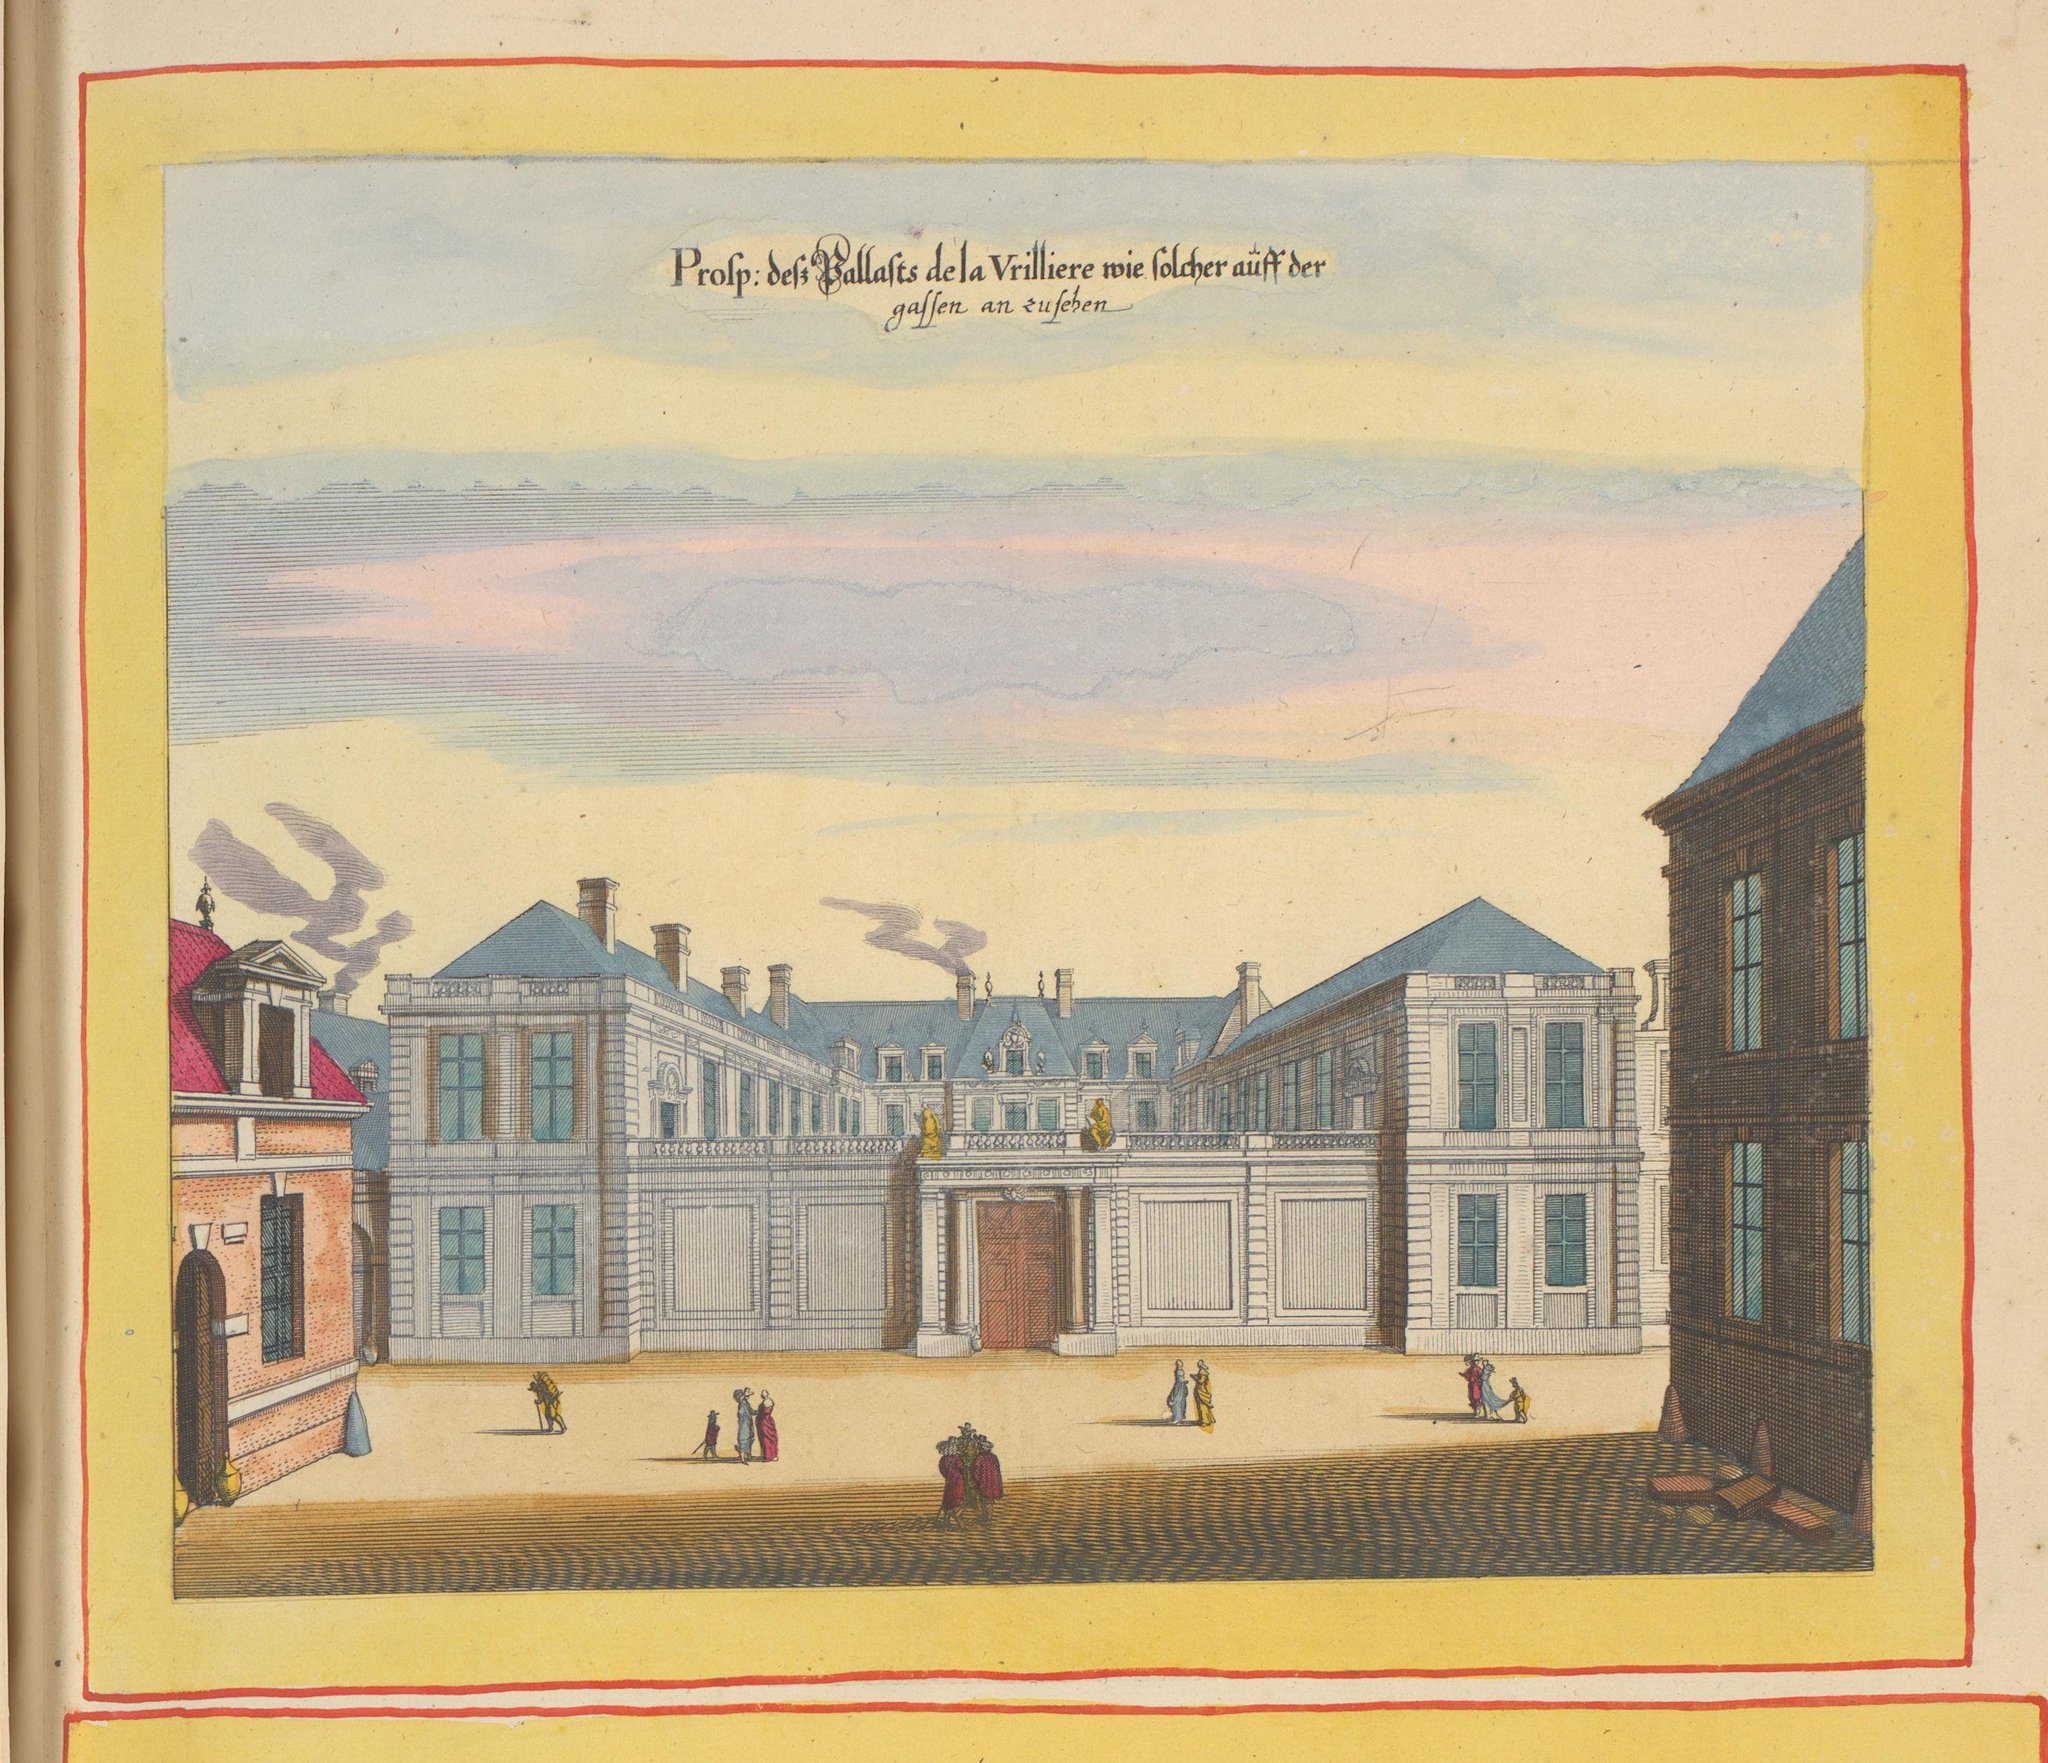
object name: print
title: Gezicht op de hoofdingang van Hôtel de La Vrillière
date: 1655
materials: paper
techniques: engraving, etching, hand coloring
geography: frankfurt am main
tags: hôtel, i.e. small palace in city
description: Prent origineel vervaardigd als boekillustratie voor: Zeiller, Martin. Topographia Galliae, oder Beschreibung und Contrafaitung der vornehmbsten und bekantisten Oerter in dem mächtigen und grossen Königreich Frankreich, 13 delen. Frankfurt am Main: Caspar Merian, 1655-1661. De prent werd voor het eerst gepubliceerd in deel 1: Topographia Galliae, 1655. De prent is langs de bovenrand van de voorstelling afgescheurd. Het bovenste gedeelte is hoger opgeplakt, zodat de lucht hoger is geworden en het formaat van de voorstelling past bij de andere groot formaatvoorstellingen in het album. De voorstelling is aan de bovenzijde aangevuld met een geschilderde lucht.